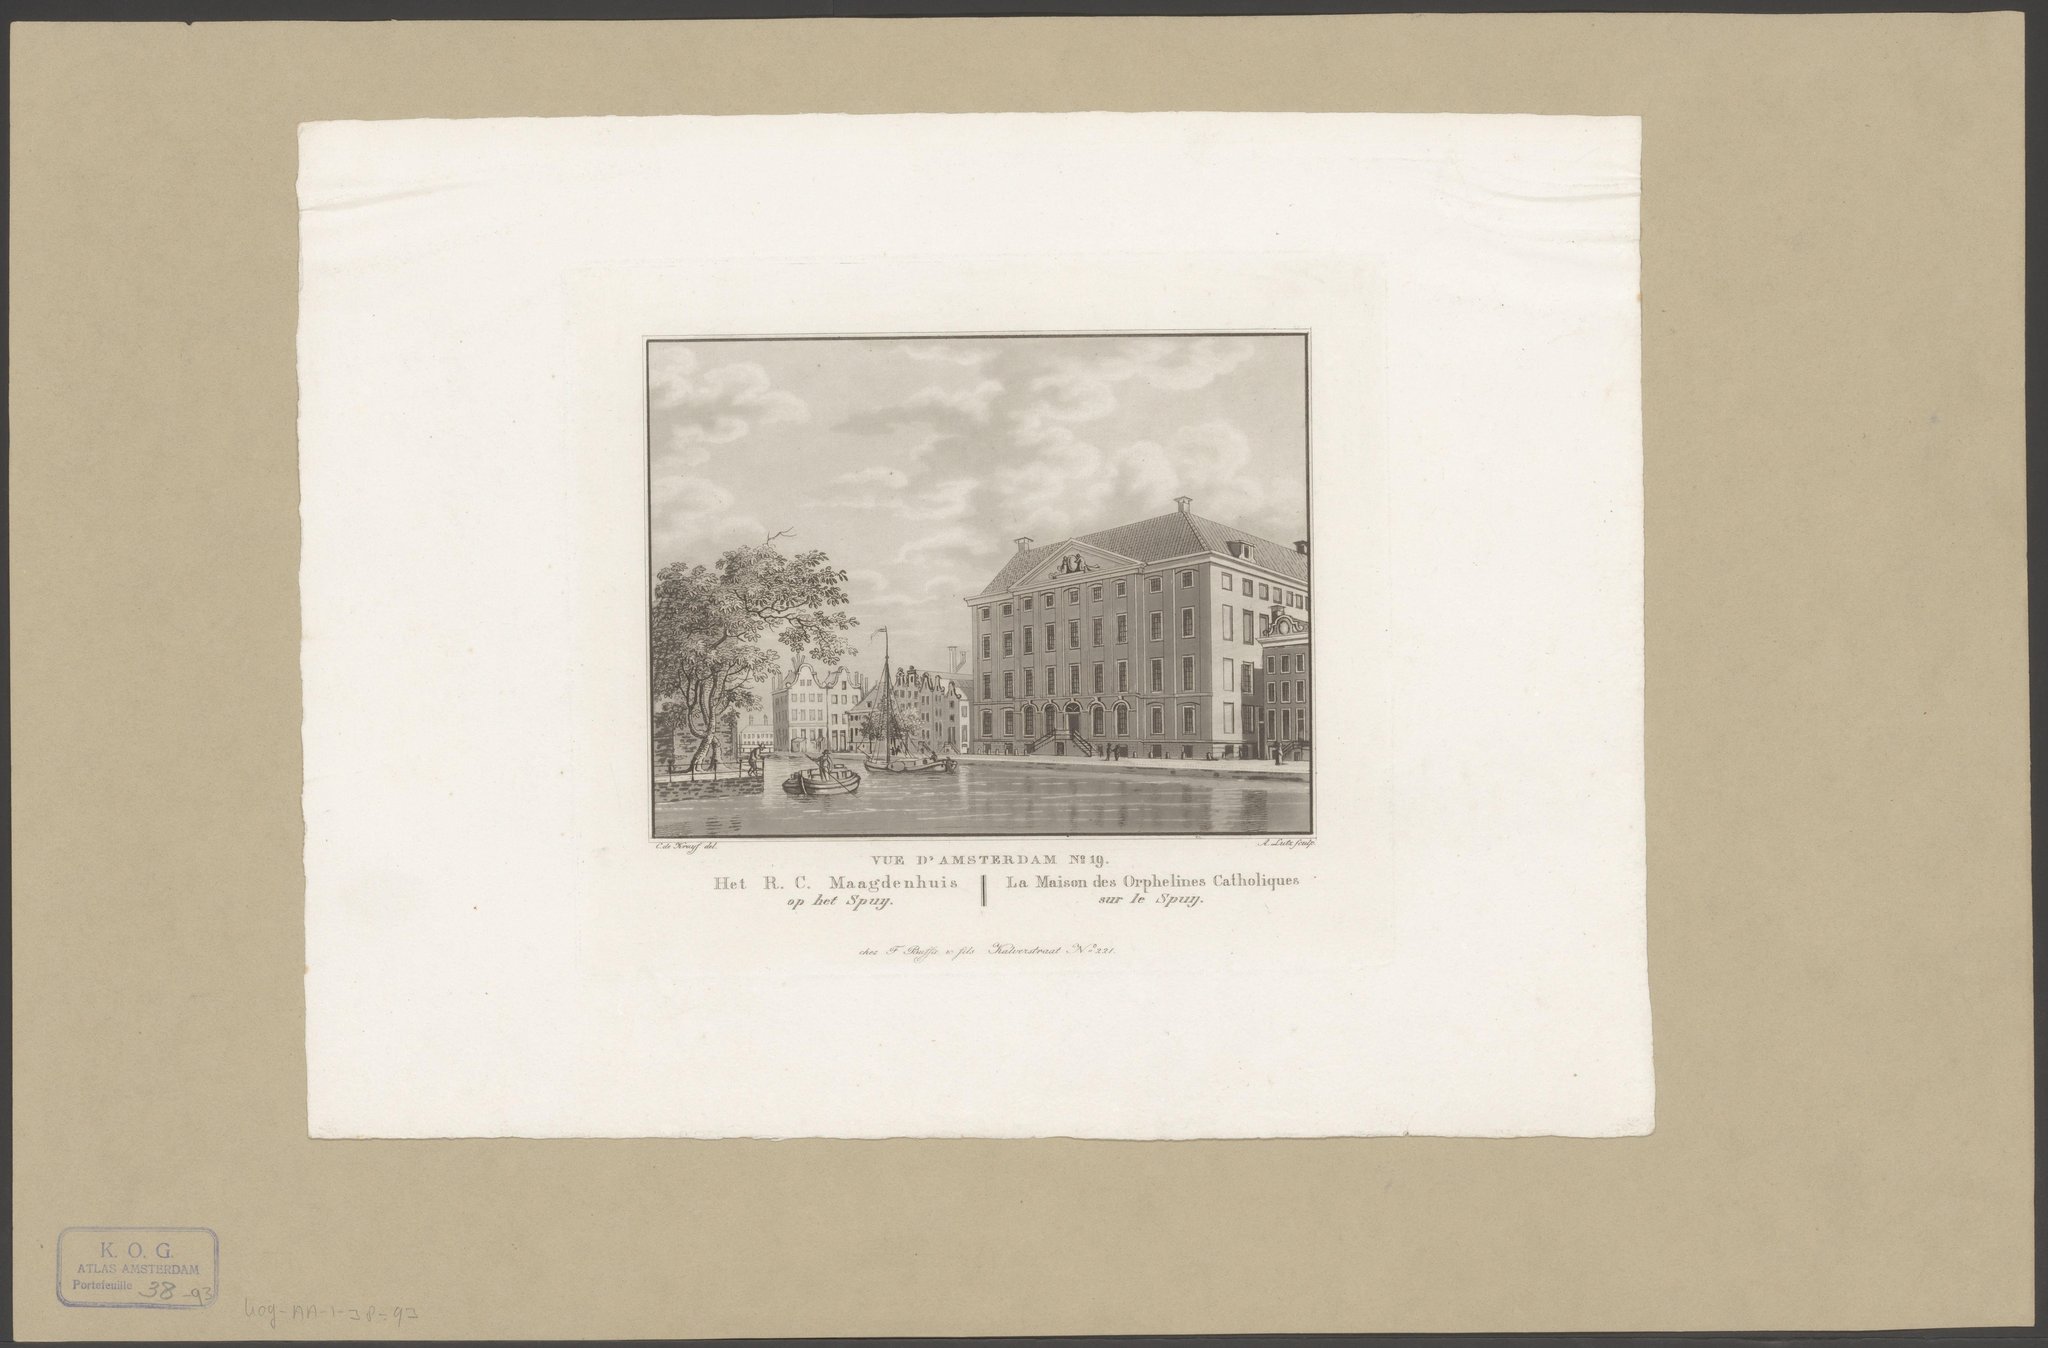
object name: print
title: Gezicht op het Maagdenhuis te Amsterdam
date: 1825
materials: paper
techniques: aquatint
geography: netherlands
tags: orphanage, canals, waters (in city) (+ city(-scape) with figures, staffage)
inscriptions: collector's mark: Lugt 1641b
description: Onderwerpsrubriek binnen de Atlas Amsterdam: Armwezen en liefdadige instellingen: II. Kerkelijke inrichtingen: Rooms-Katholijk Maagden of Meisjesweeshuis.